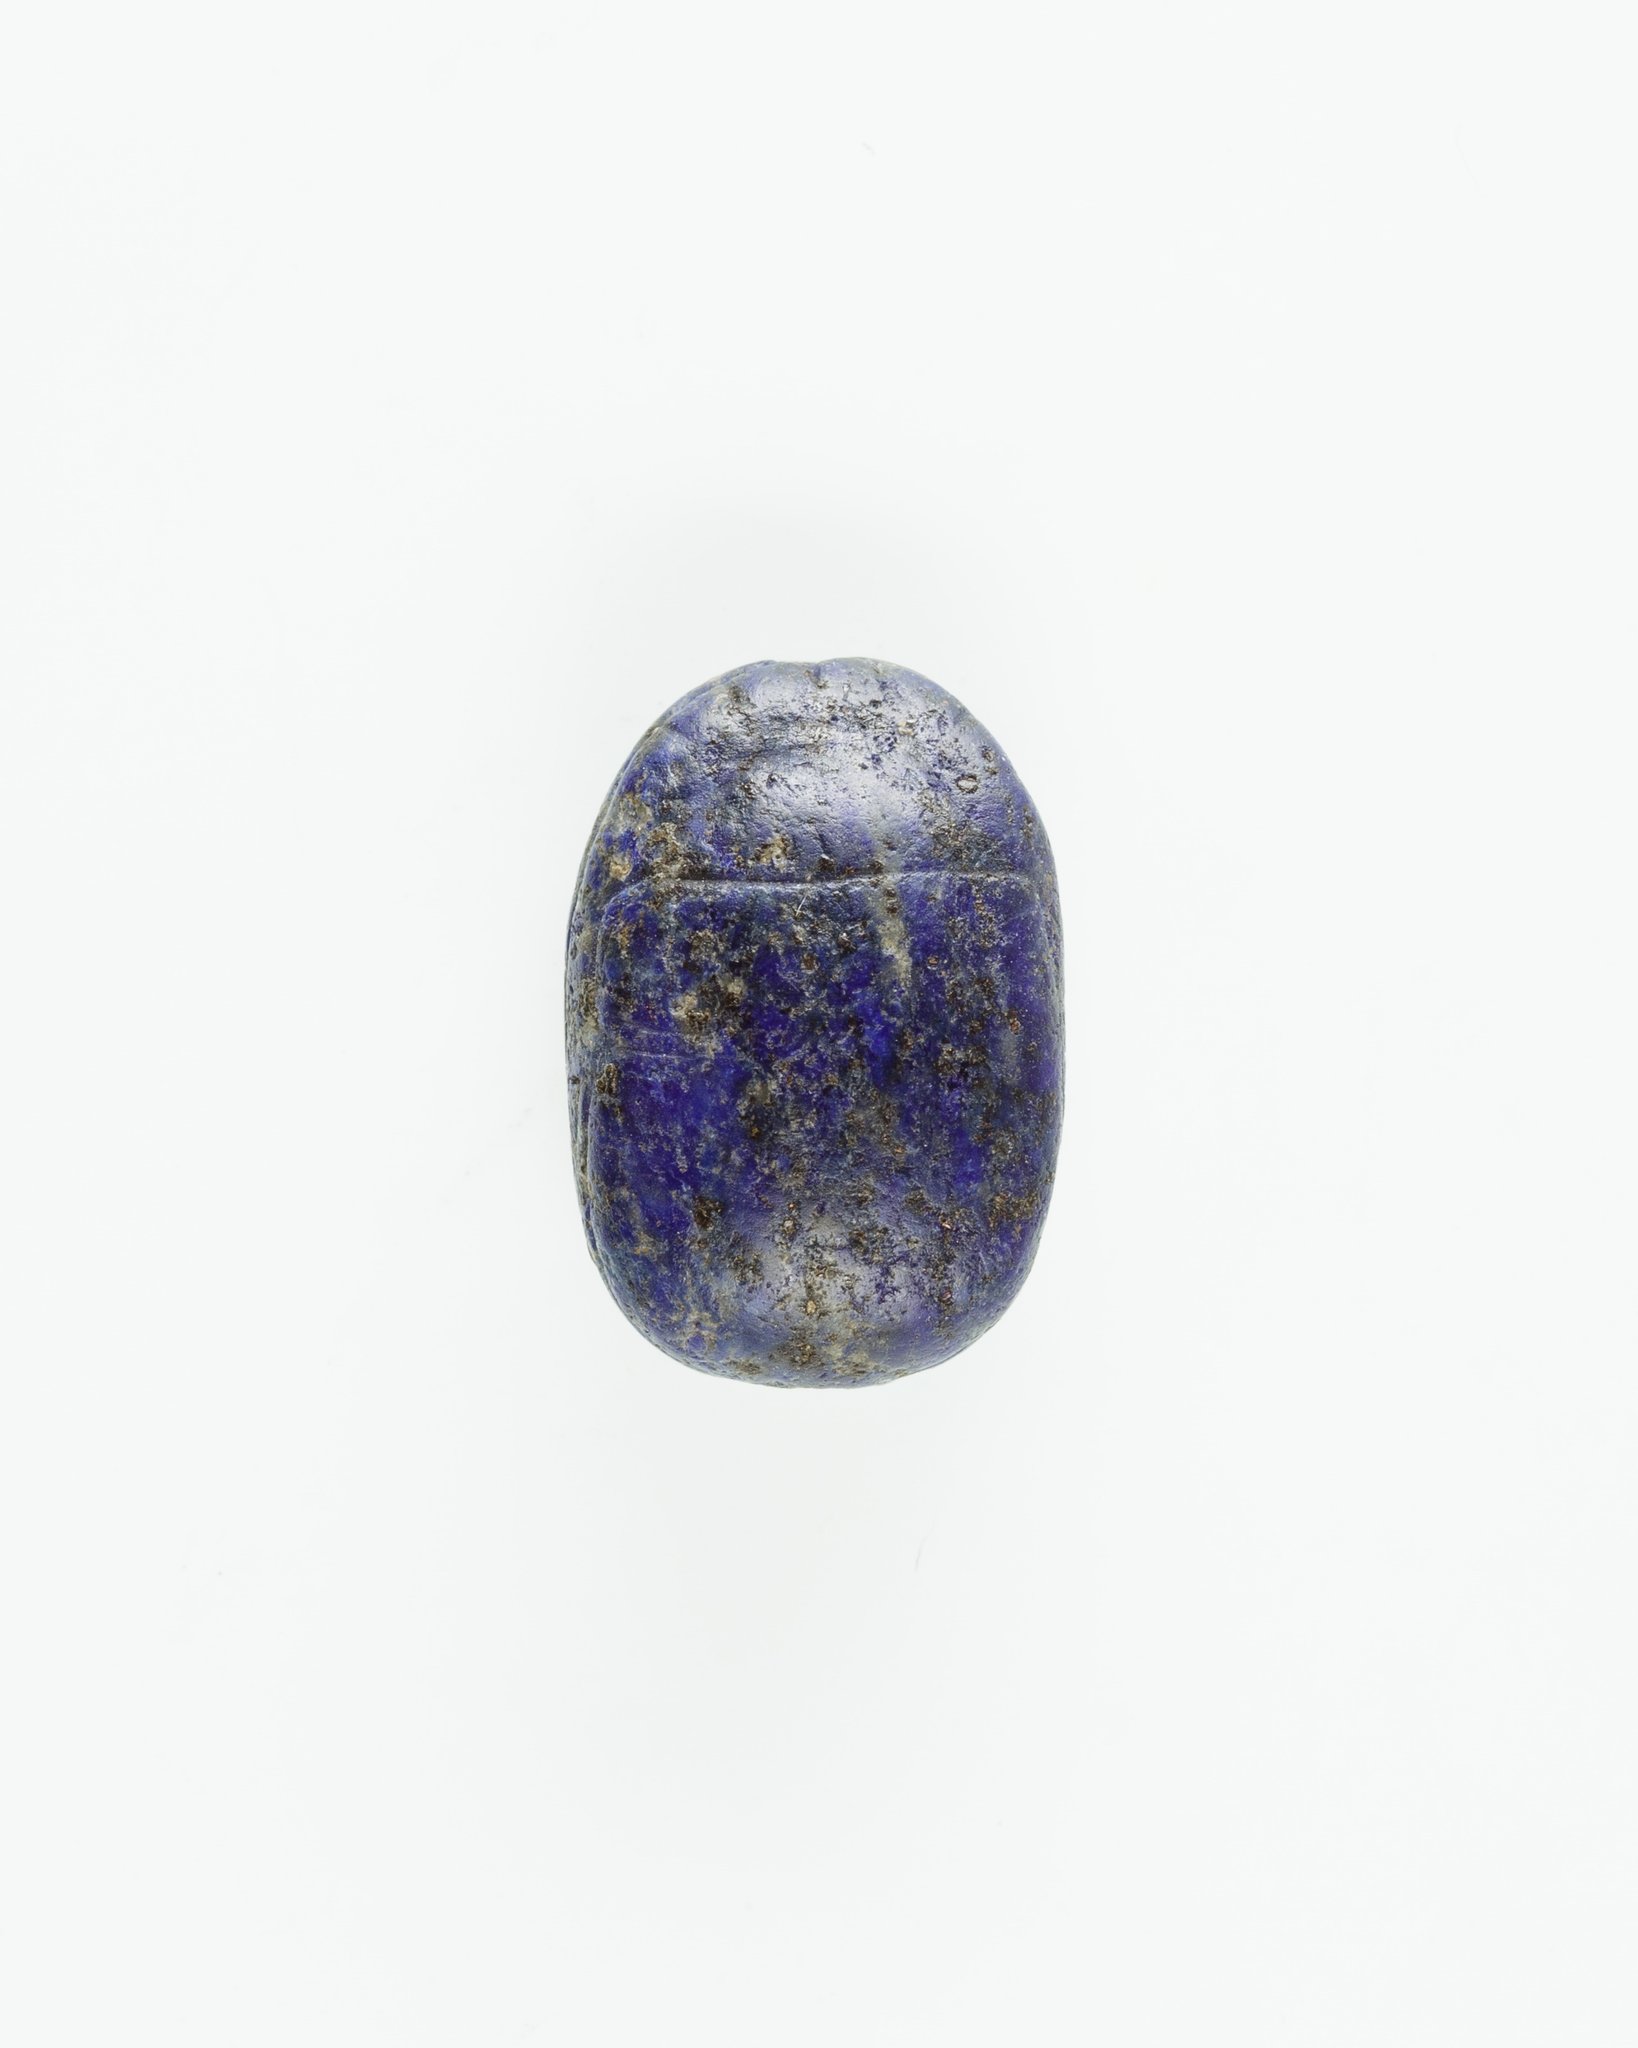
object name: scarab, uninscribed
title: Uninscribed scarab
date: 1981-1802 BCE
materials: lapis lazuli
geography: egypt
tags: scarabs